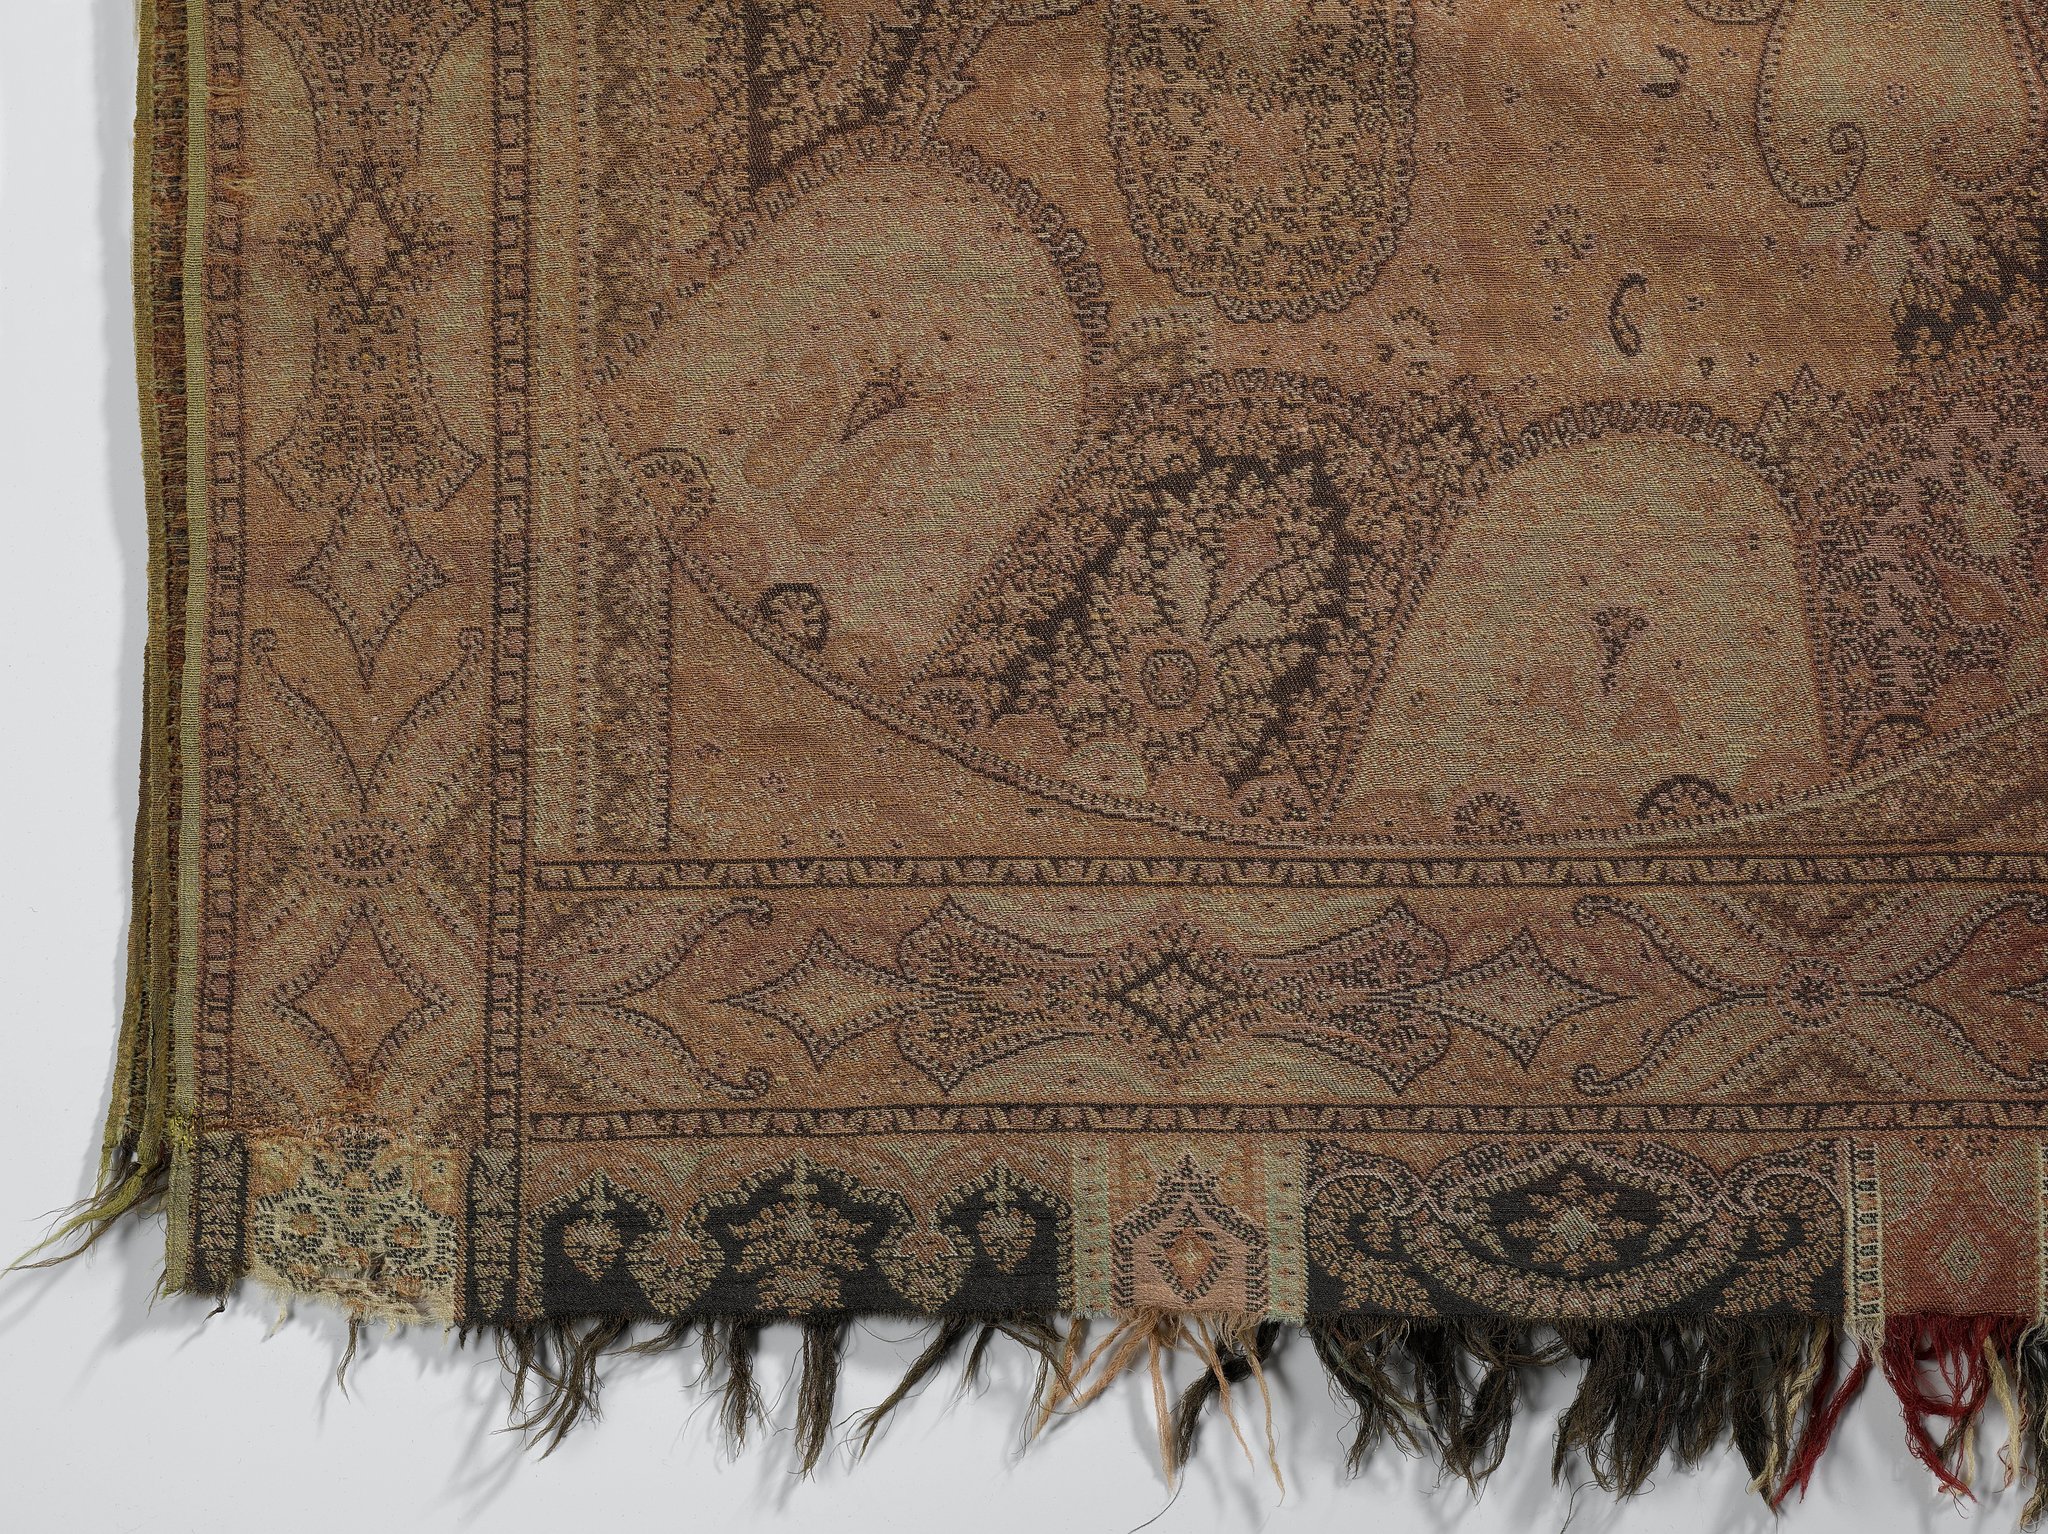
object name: clothing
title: Langwerpige sjaal met zwarte spiegel, waaromheen een vol ornamentaal patroon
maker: Anonymous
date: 1860-1880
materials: wool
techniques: weave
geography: western europe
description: Langwerpige sjaal met zwarte spiegel, waaromheen een vol ornamentaal patroon